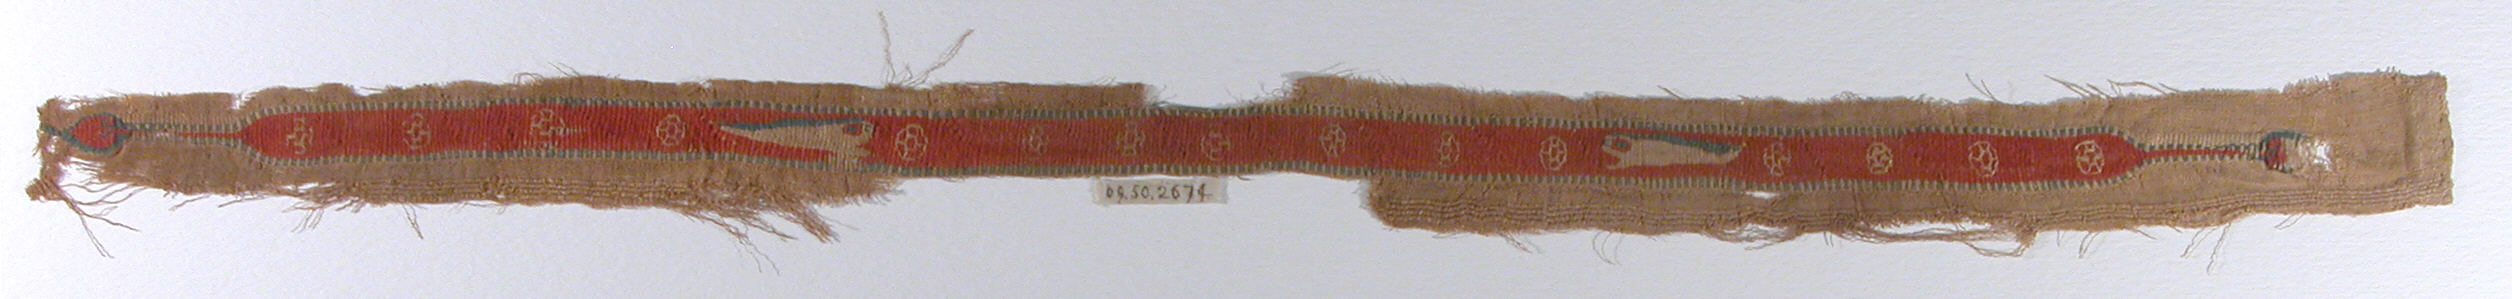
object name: shoulder band fragment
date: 401-500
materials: linen, wool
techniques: weave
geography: egypt